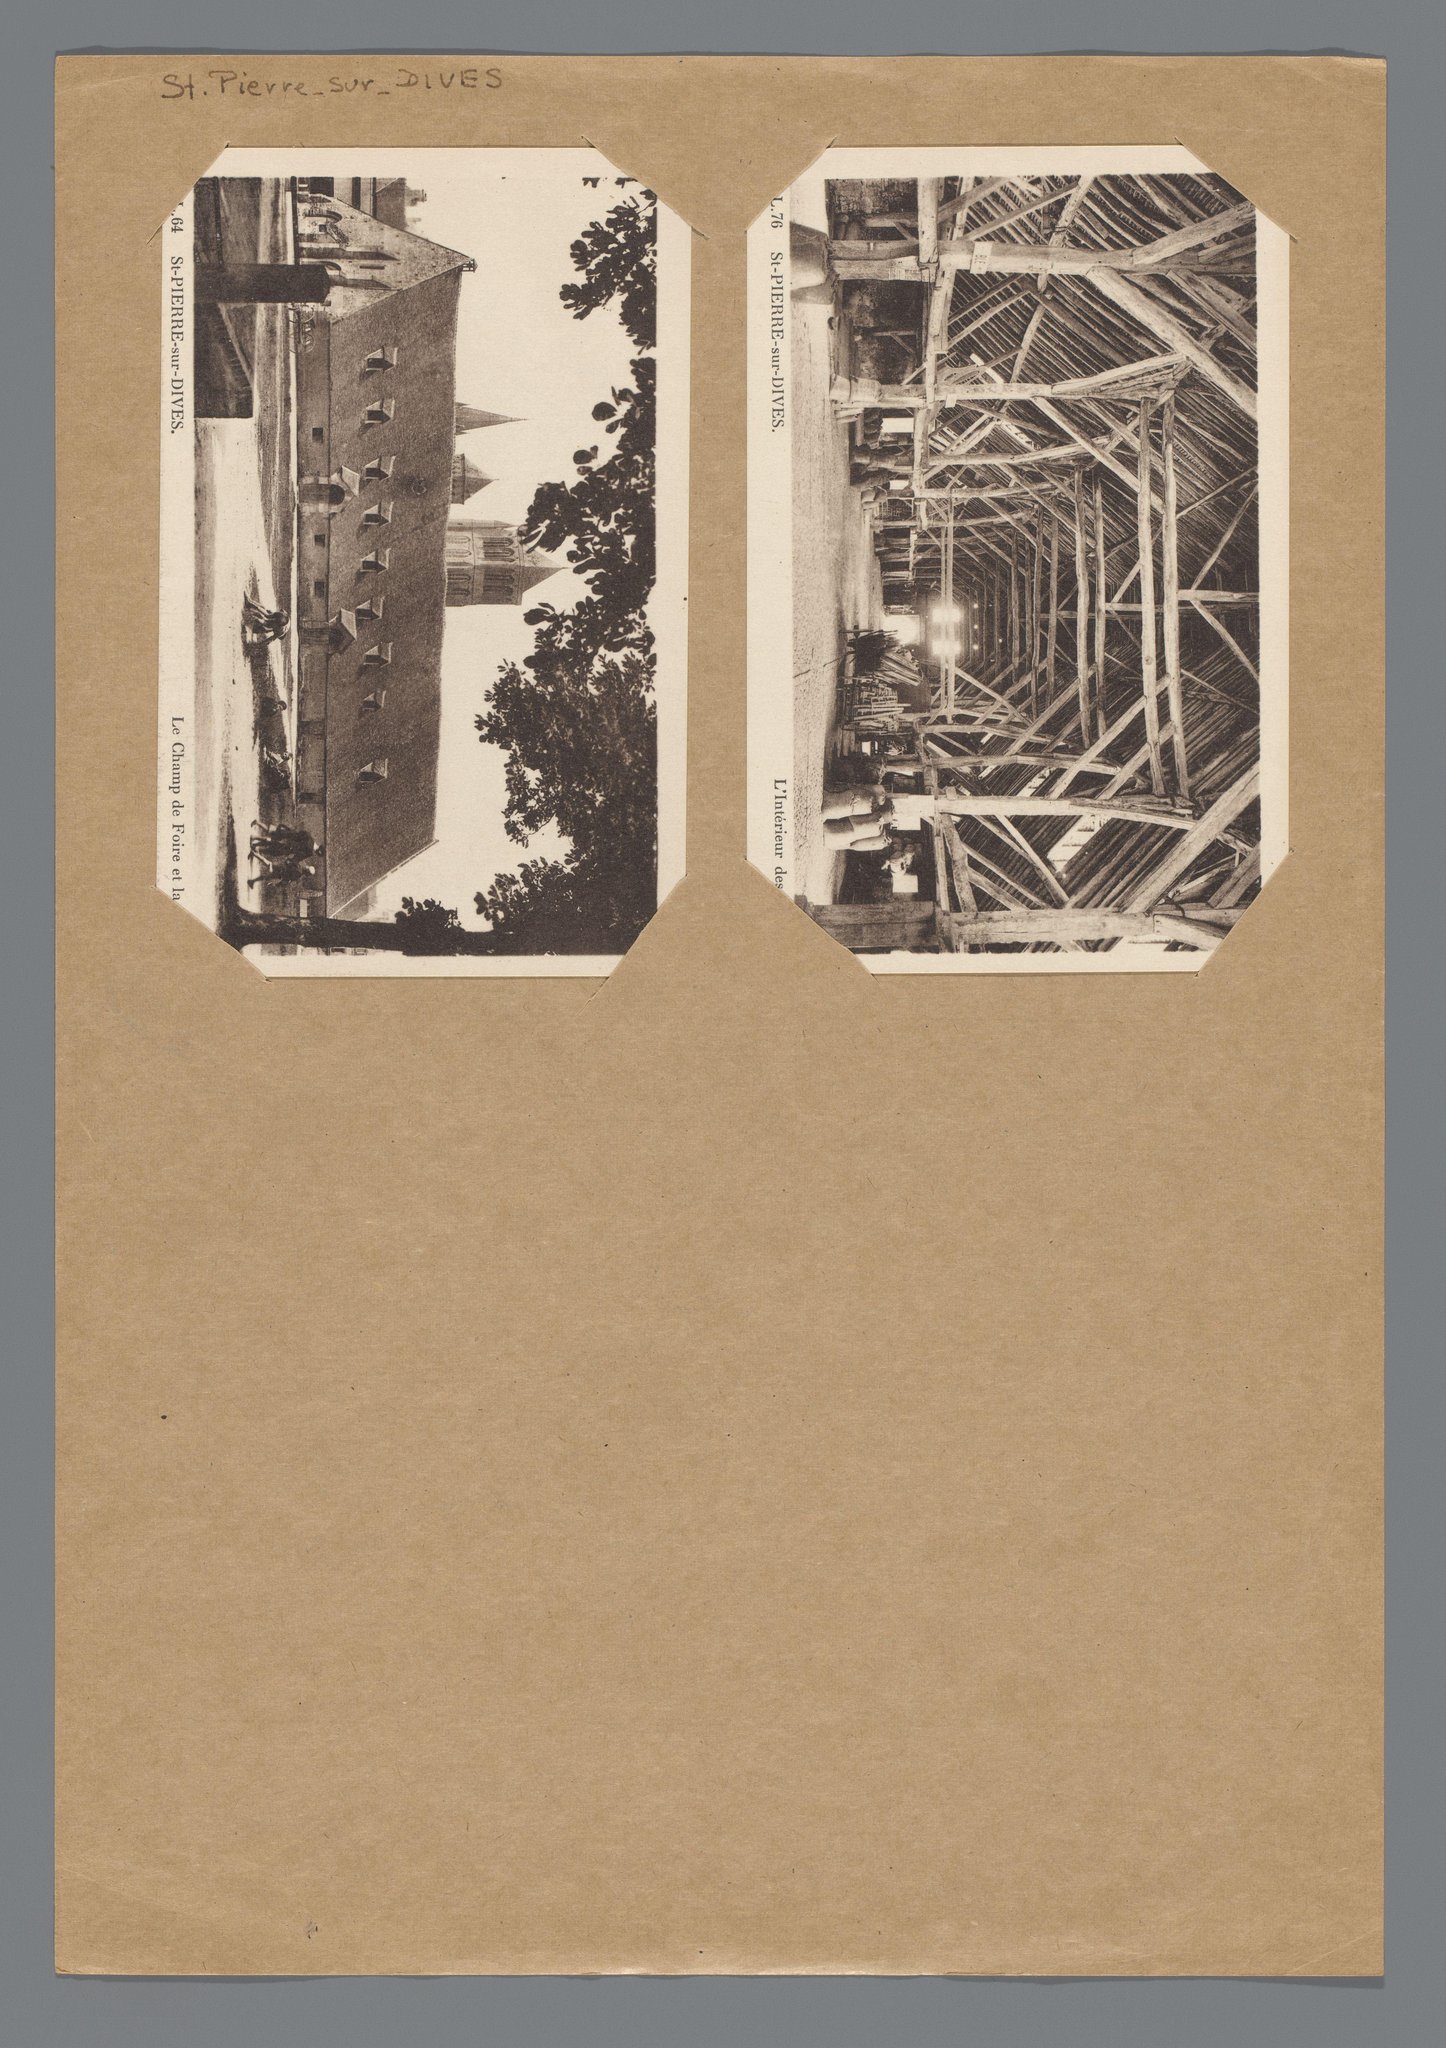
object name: photograph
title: St. Pierre sur Dives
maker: Anonymous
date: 1860-1930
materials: paper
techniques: photograph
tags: saint-pierre-sur-dives